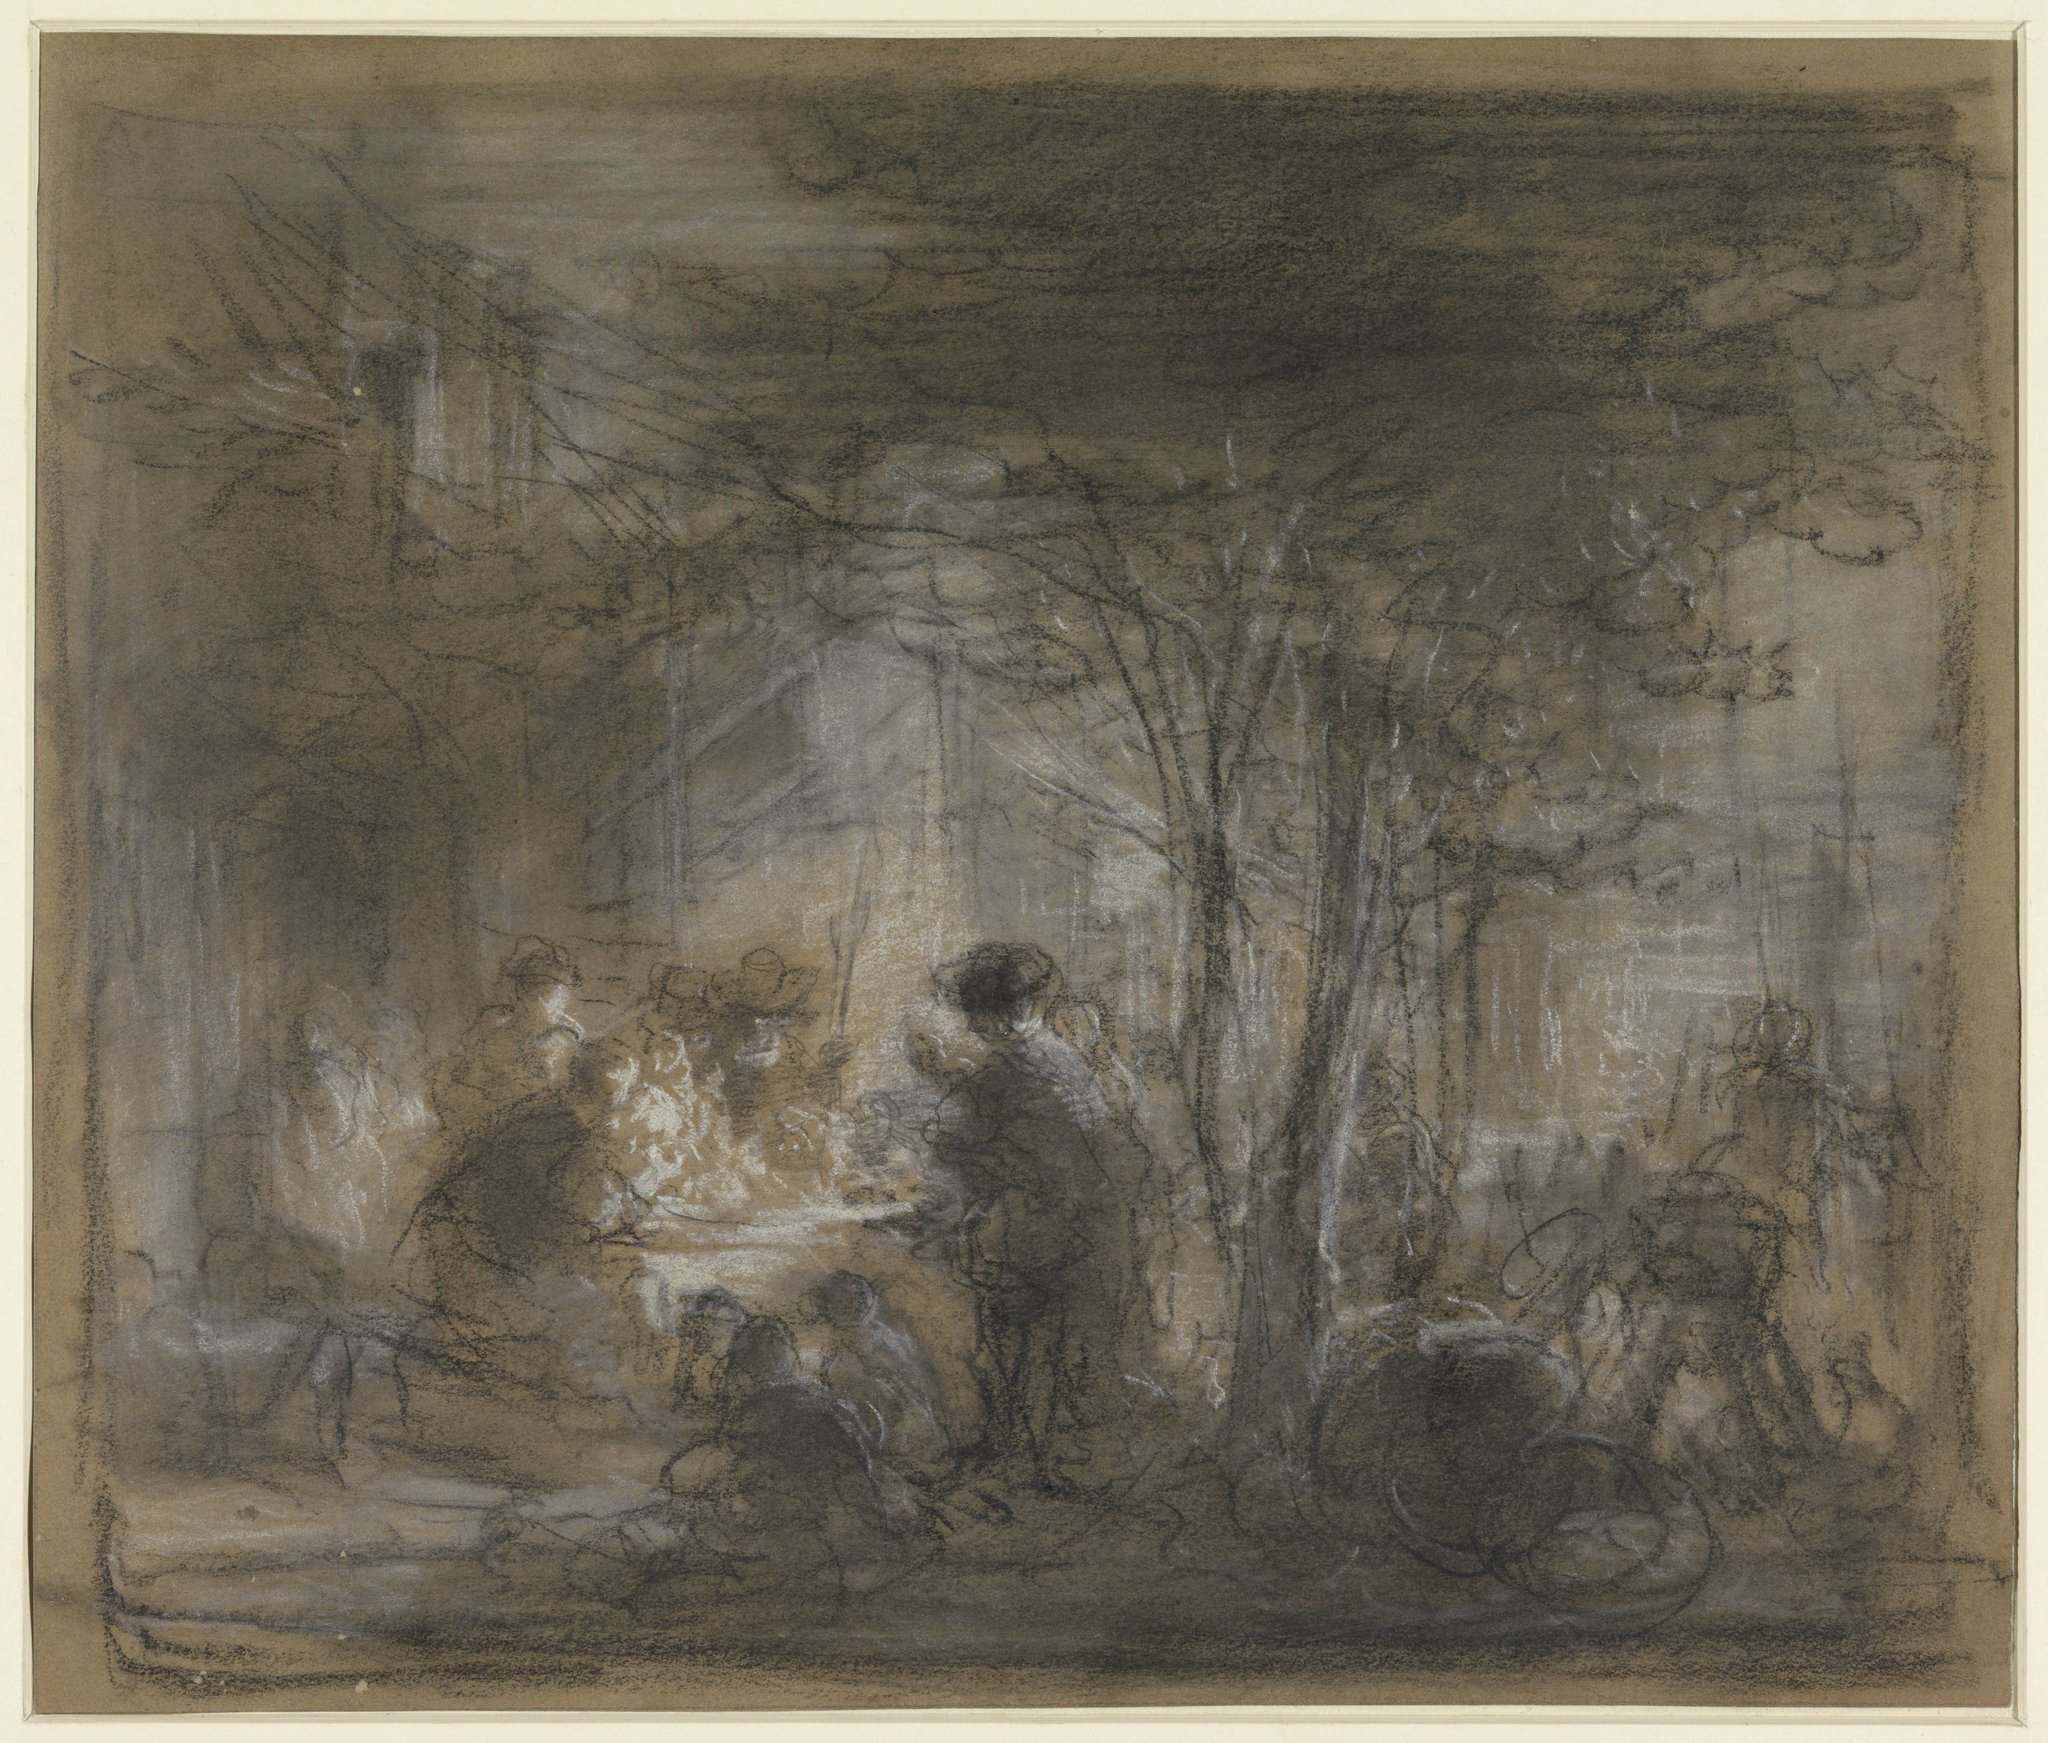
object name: drawing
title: Gezelschap rond een tafel onder bomen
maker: eugène françois de block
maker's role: draughtsman, painter, print maker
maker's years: 1812-1893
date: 1822-1893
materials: chalk, paper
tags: pavement, terrace in front of inn or restaurant